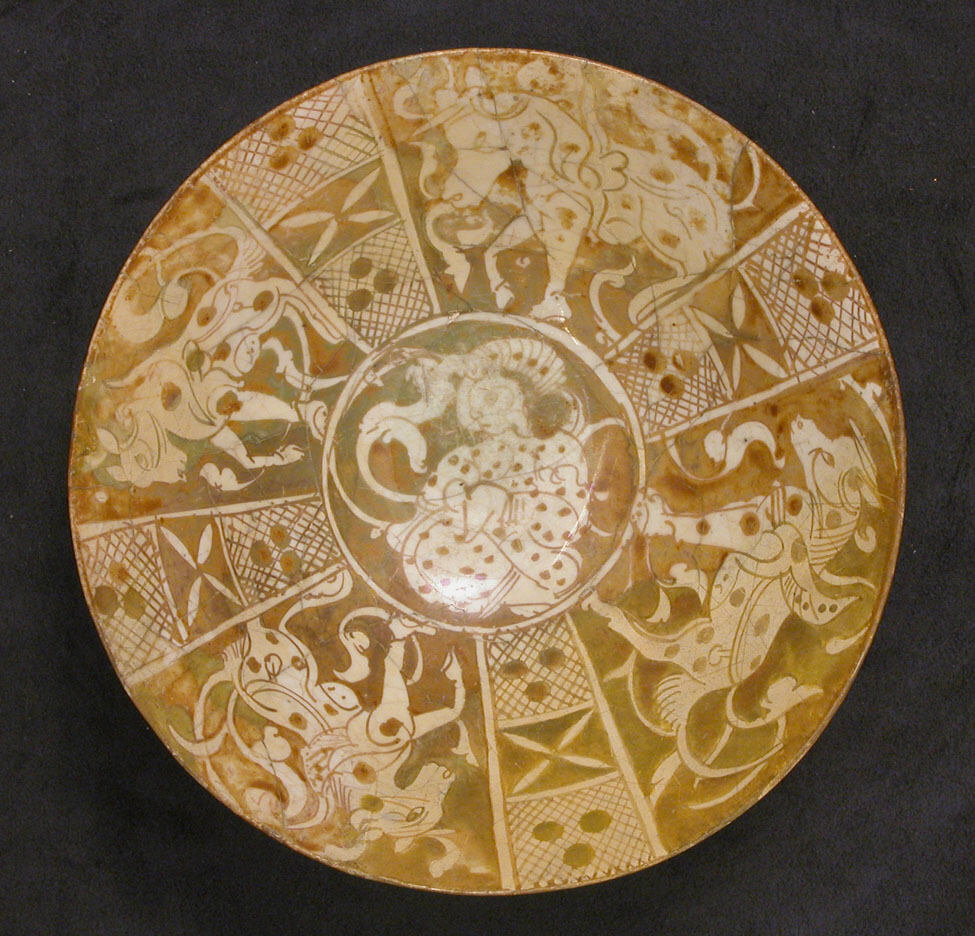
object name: bowl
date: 1101-1300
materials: glaze, stonepaste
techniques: luster painting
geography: iran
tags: animals,women